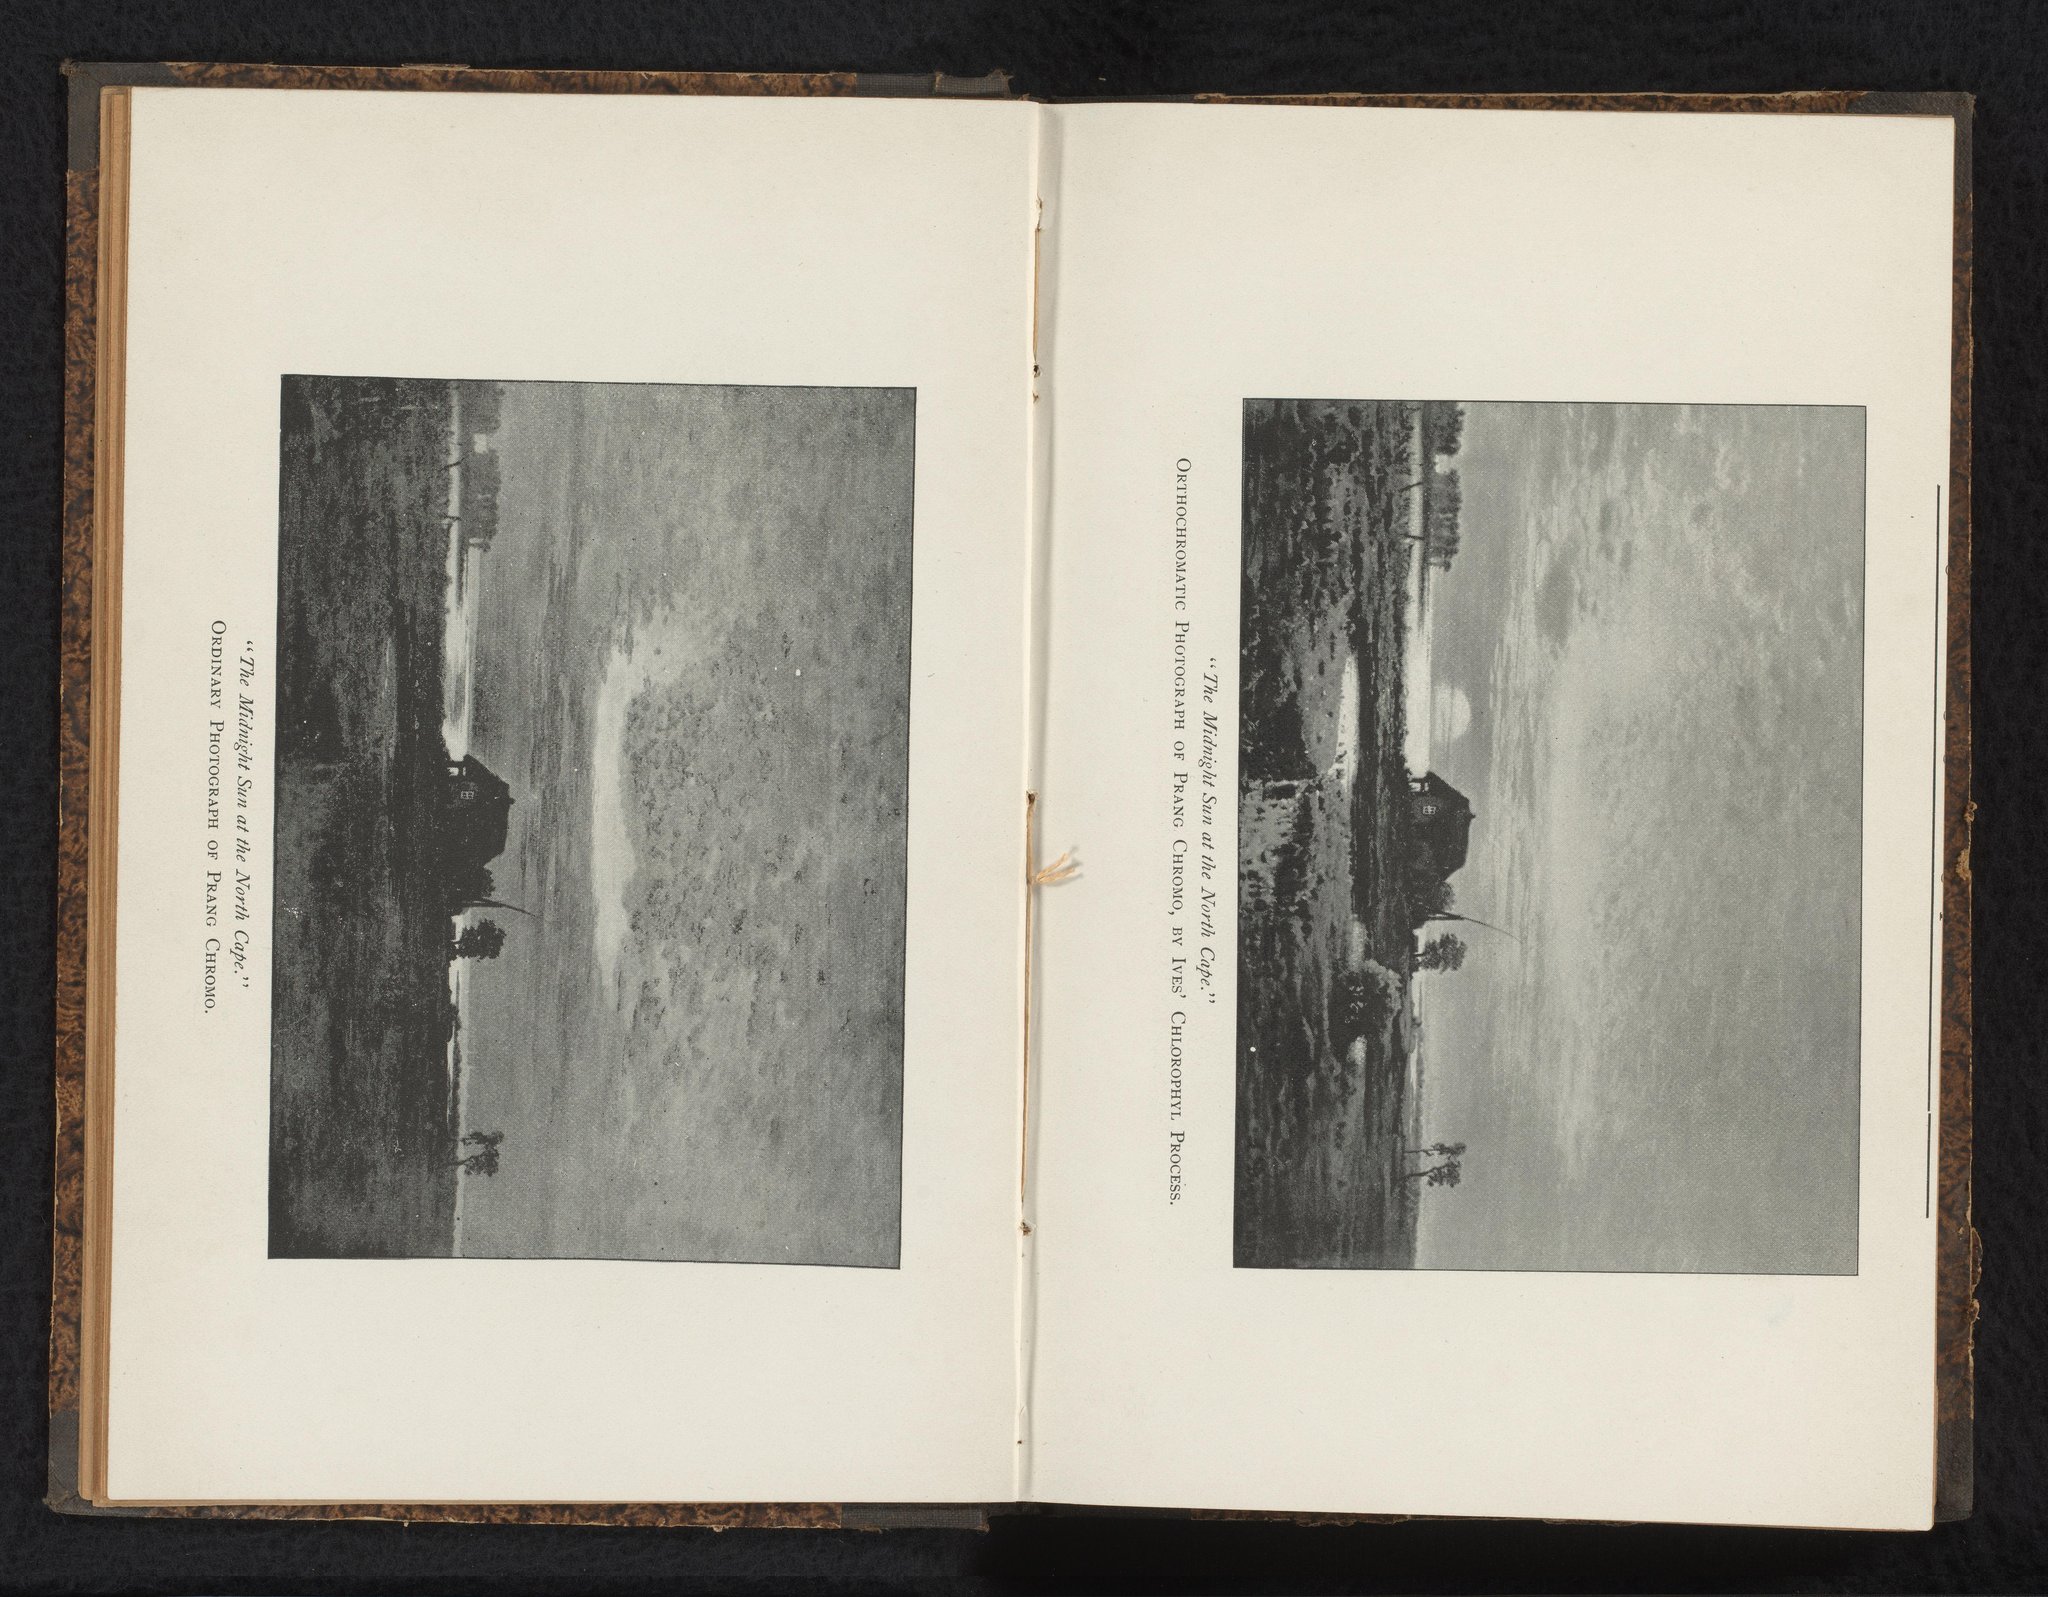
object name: page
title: Reproductie van de kleurenlithografie The Midnight Sun at the North Cape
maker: Anonymous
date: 1882-1887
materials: paper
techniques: autotype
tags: midnight sun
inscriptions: inscription: ‘Orthochrome photograph of Prang Chromo, by Ives' Chlorophyl Process.’